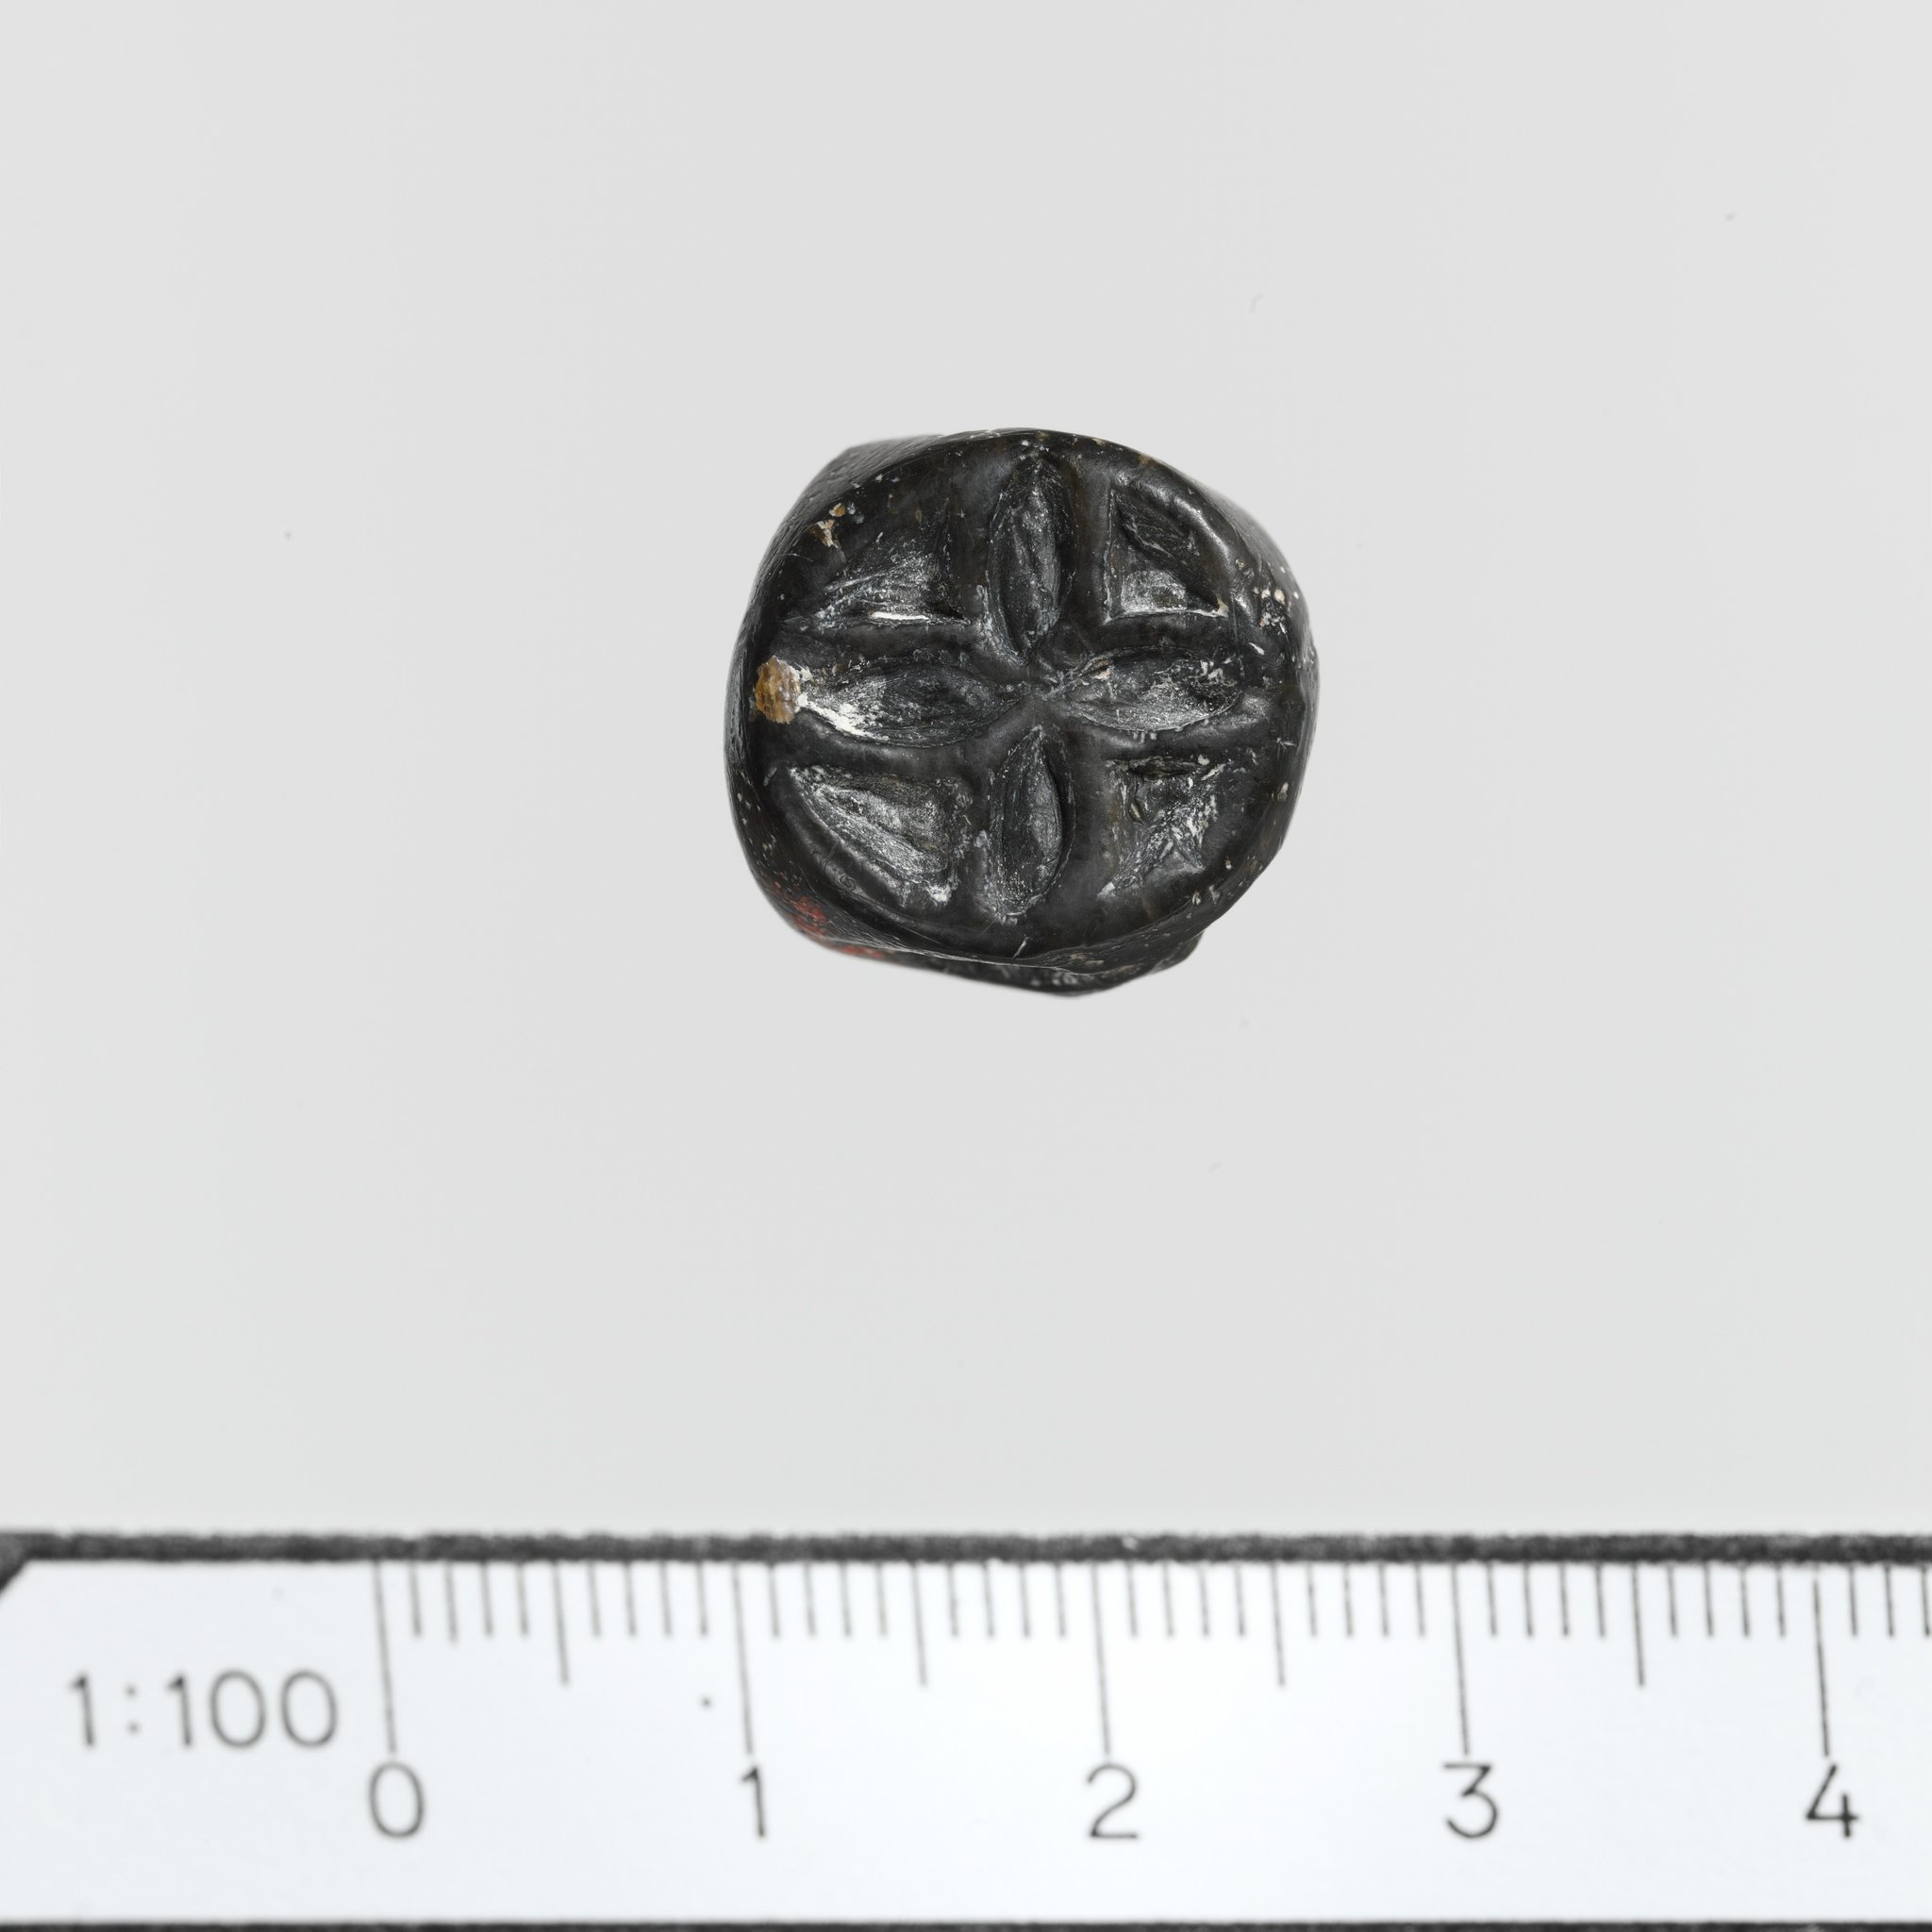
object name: seal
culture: minoan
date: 2600-2000 BCE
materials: stone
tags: flowers